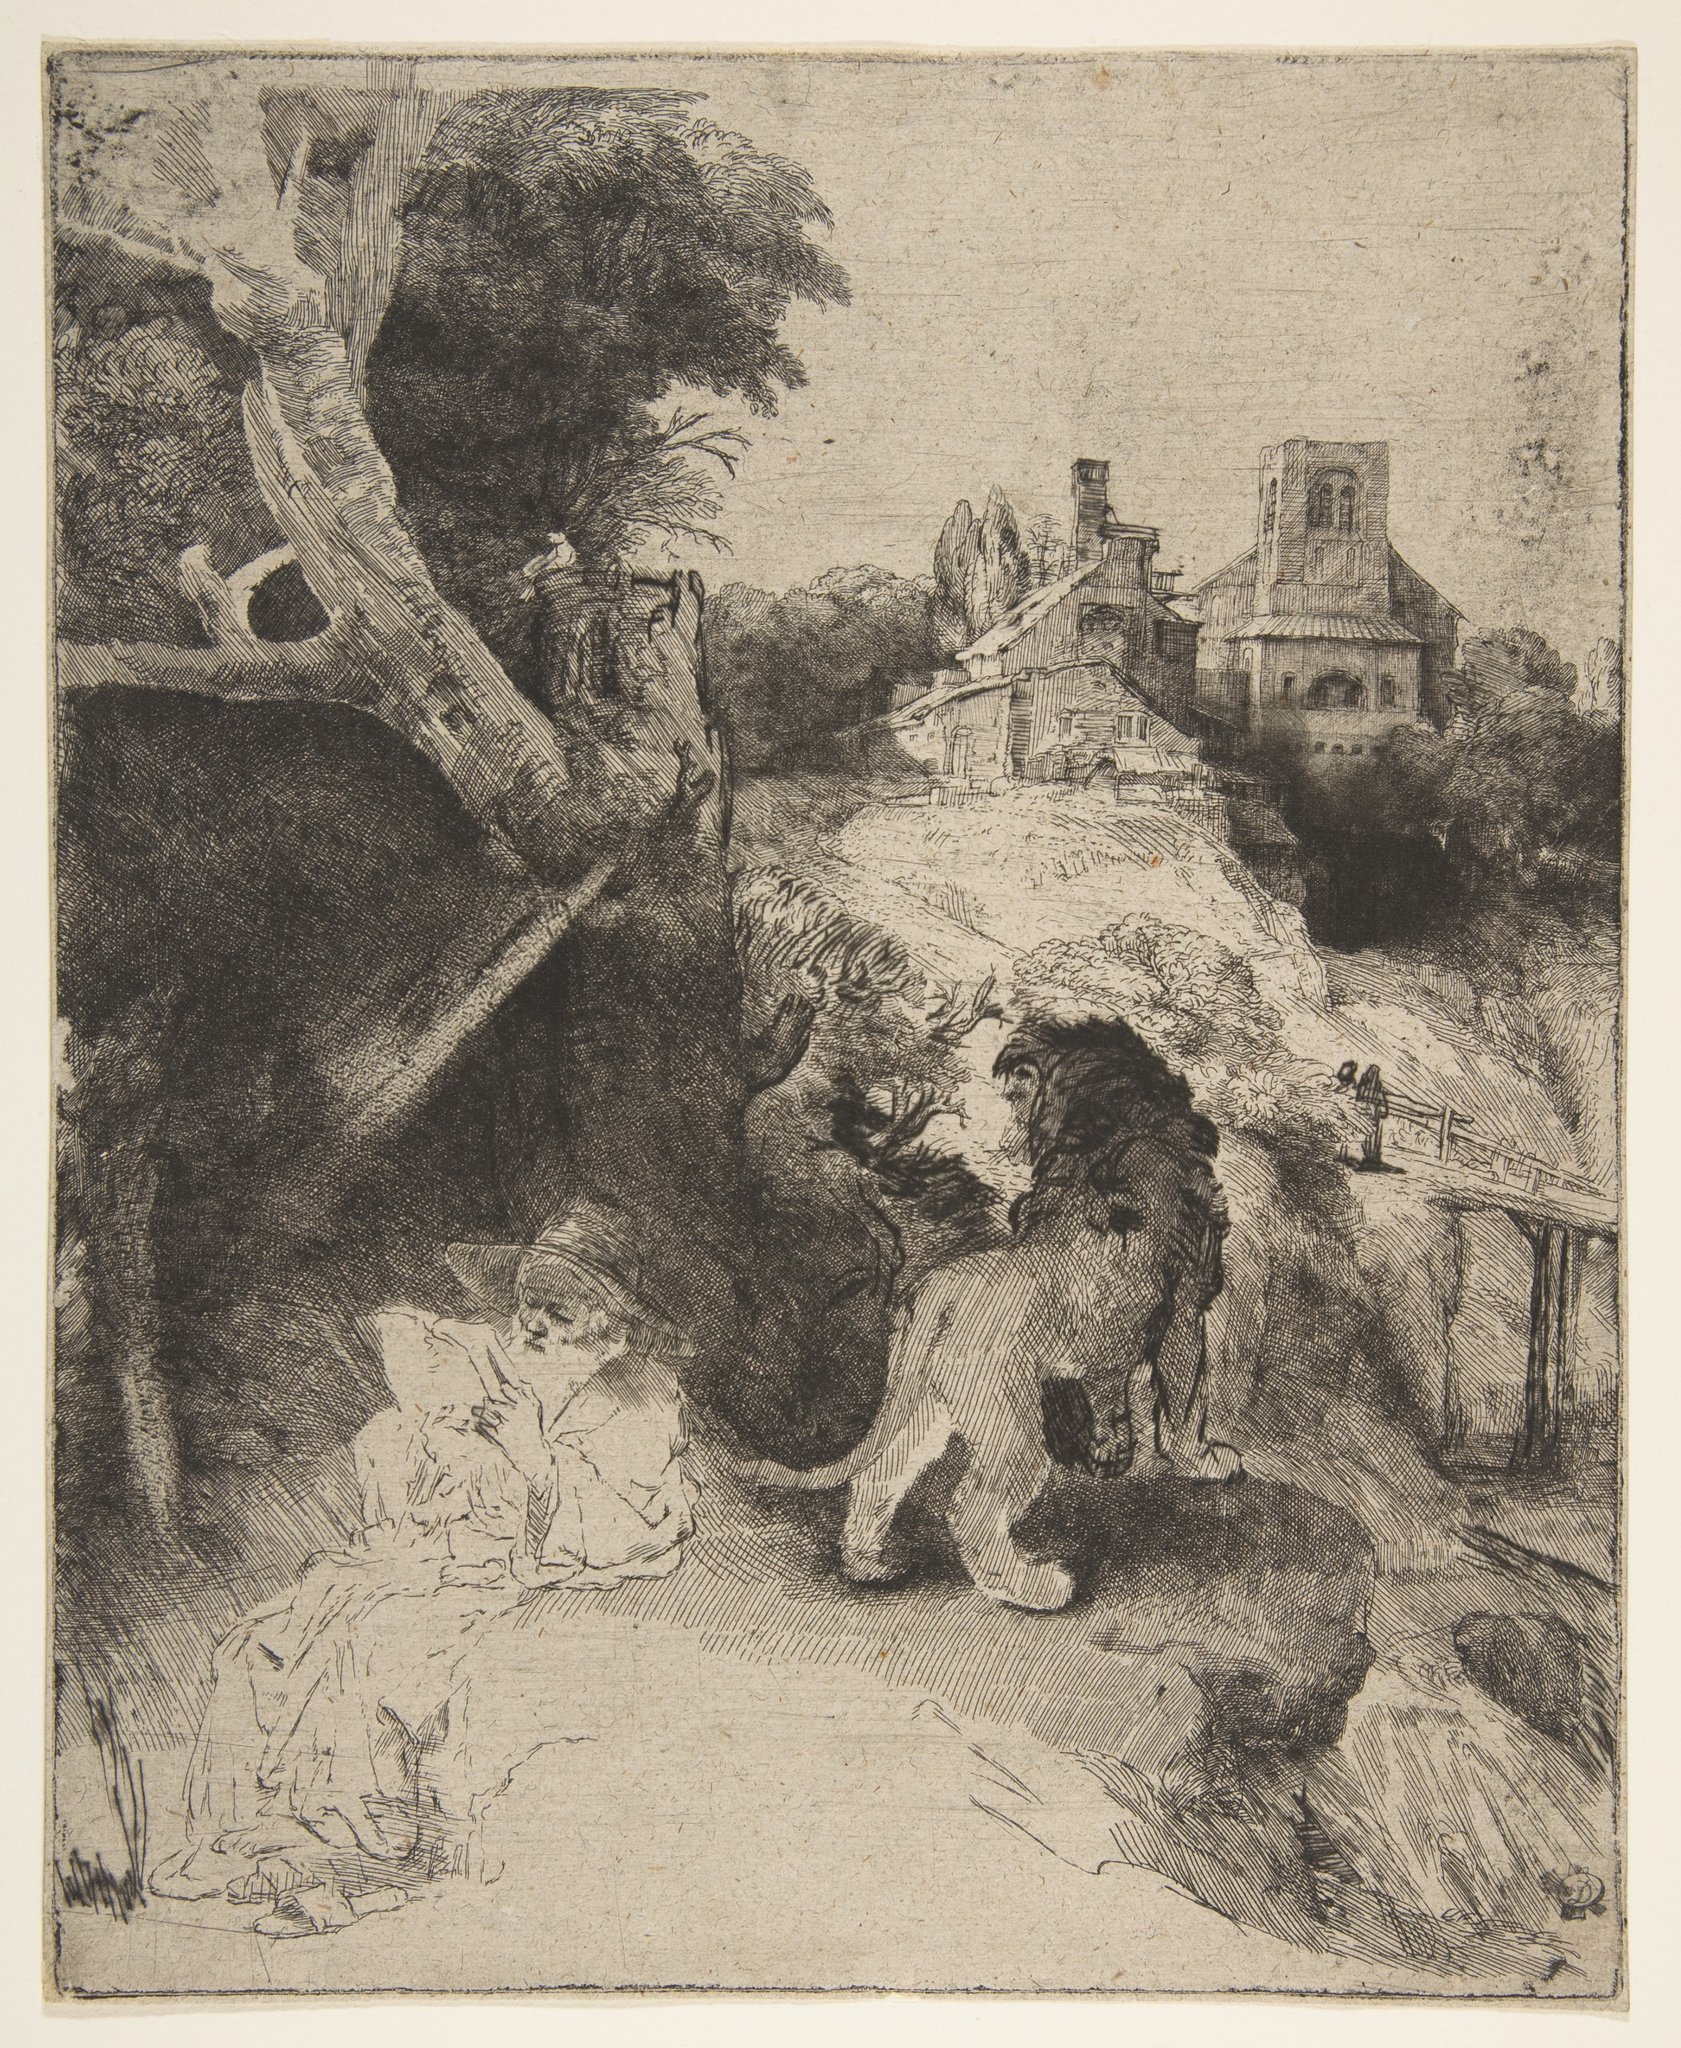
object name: print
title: St. Jerome Reading in an Italian Landscape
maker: rembrandt van rijn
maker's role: artist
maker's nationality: dutch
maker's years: 1606-1669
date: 1653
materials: paper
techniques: drypoint, engraving, etching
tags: buildings,reading,lions,landscapes,saint jerome